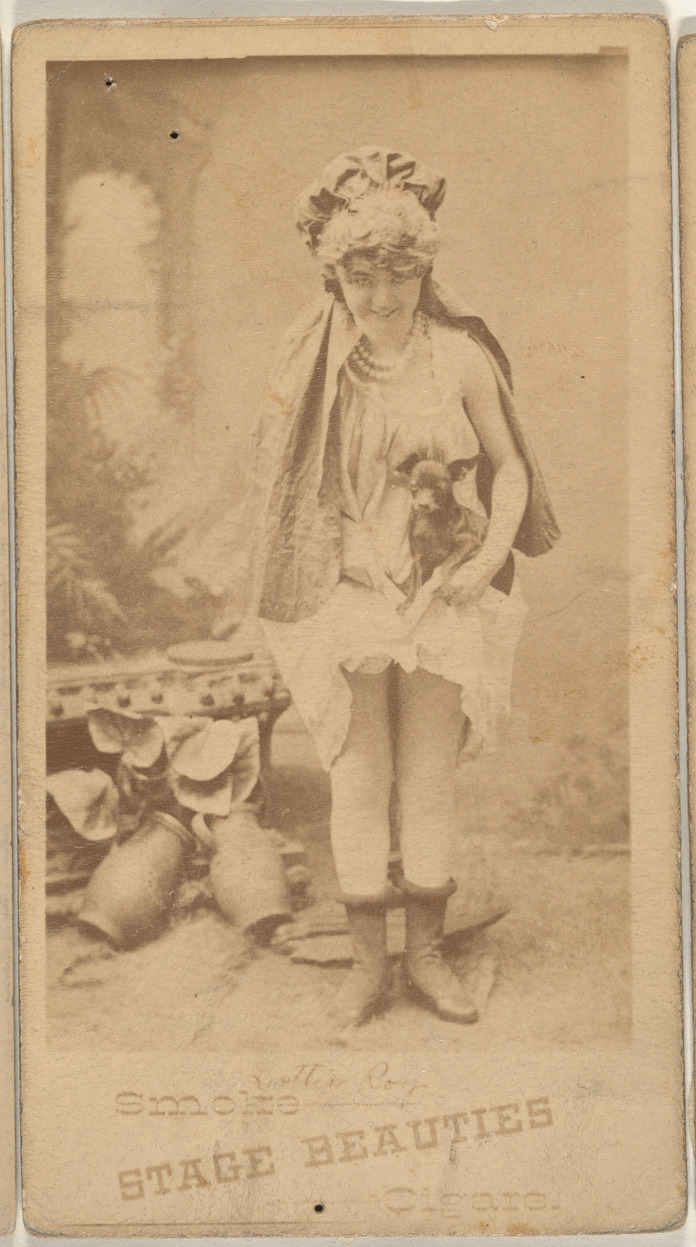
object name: photograph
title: Lottie Roy, from the Actresses series (N666) to promote Stage Beauties Cigars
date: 1888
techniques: albumen silver print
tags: portraits,women,actresses